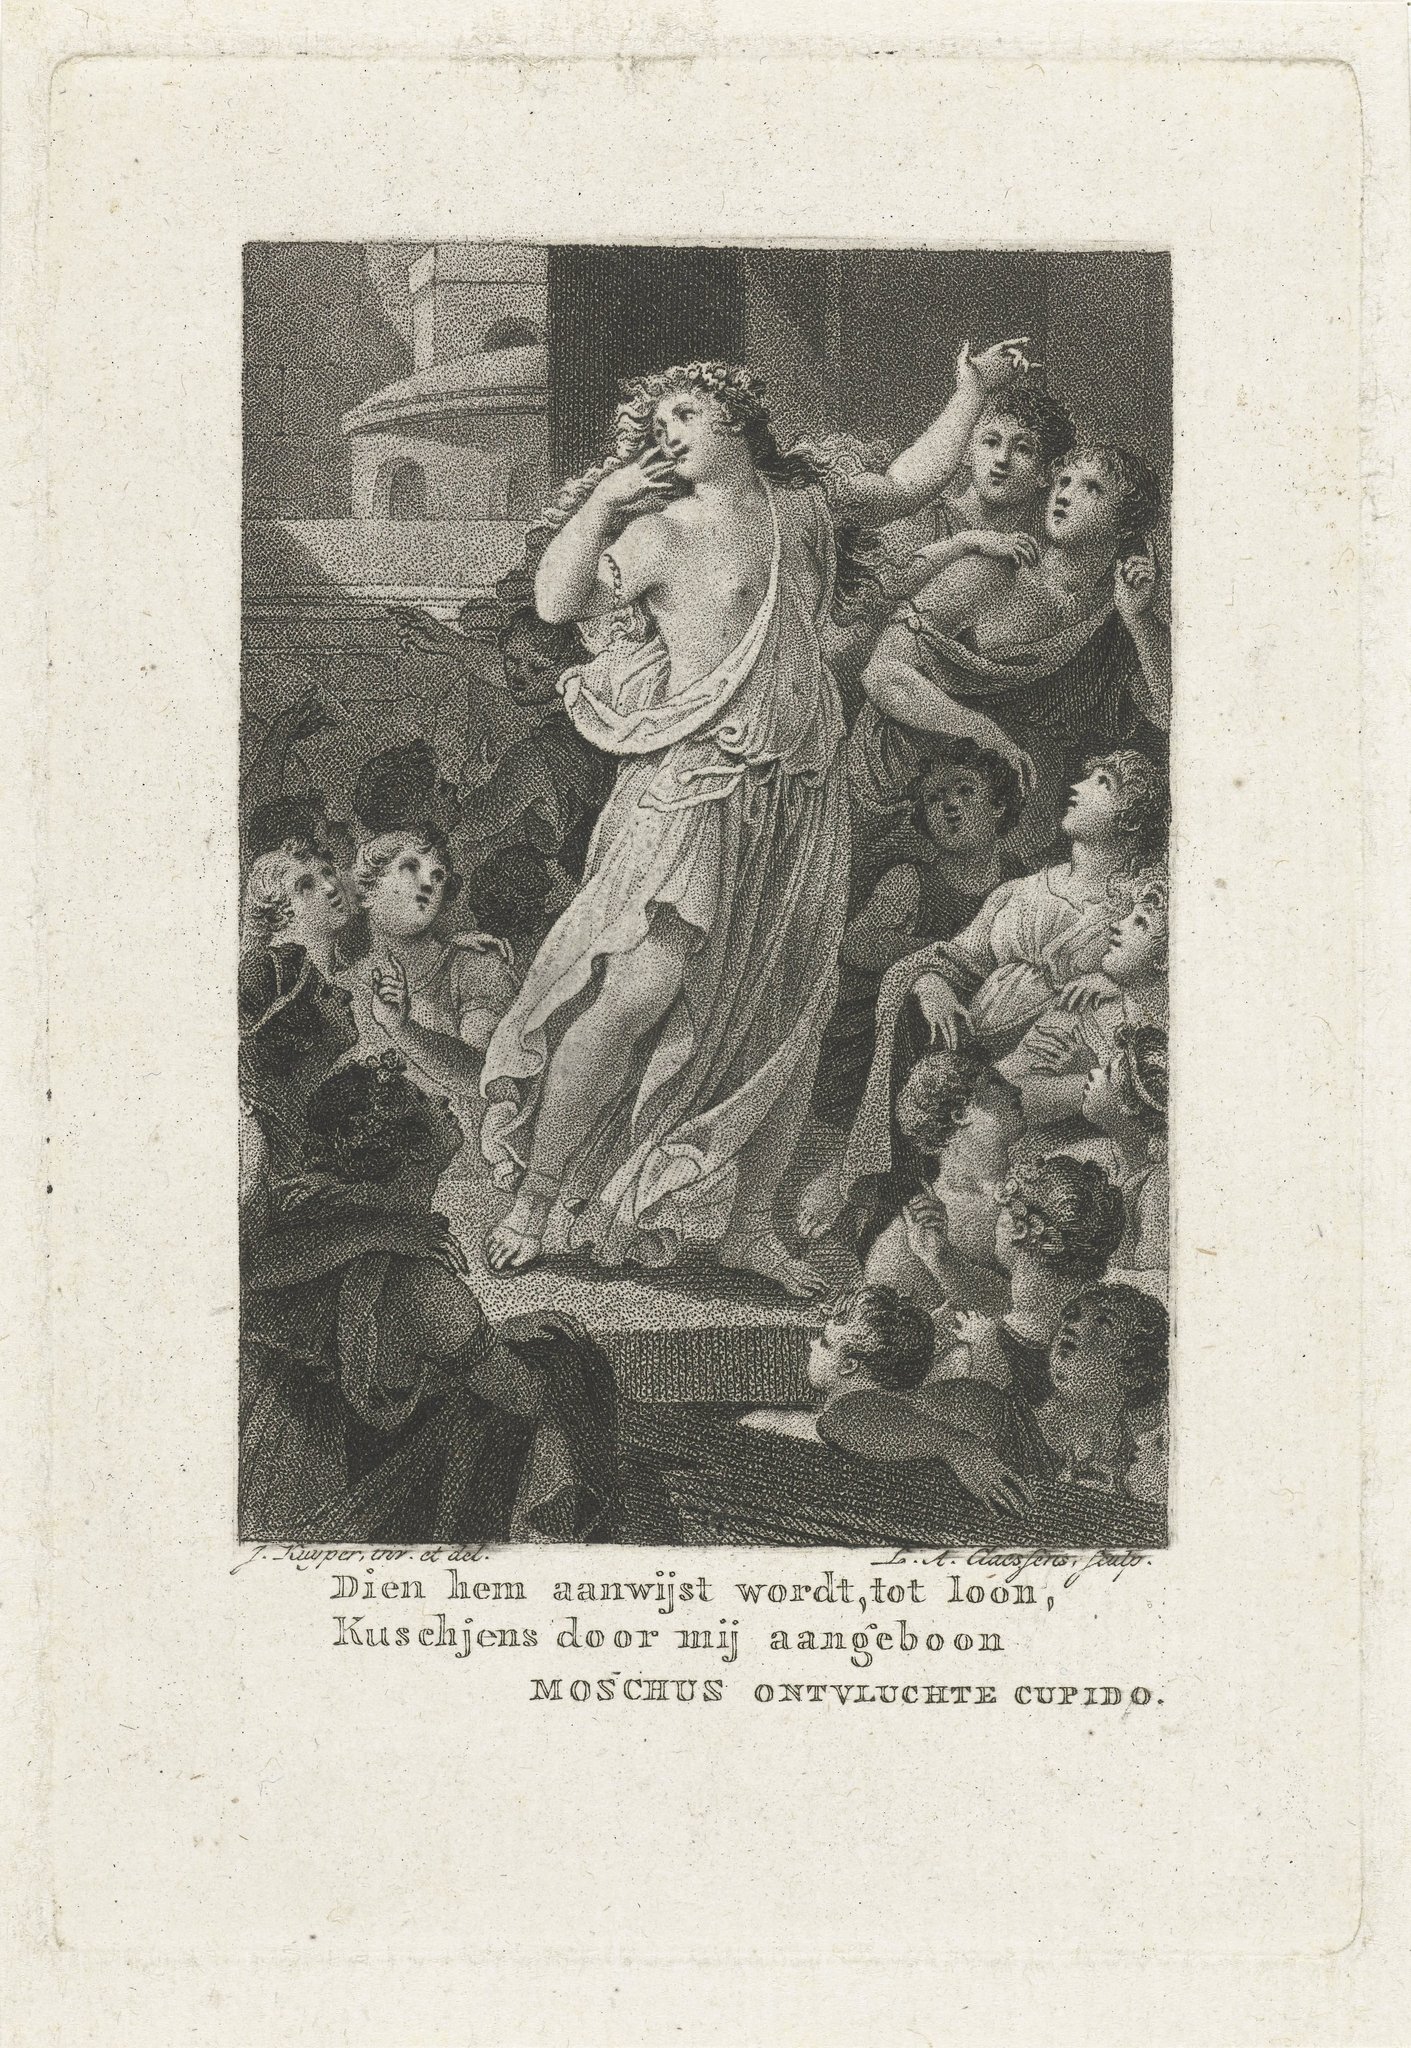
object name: print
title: De voortvluchtige Amor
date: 1803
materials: paper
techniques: etching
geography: amsterdam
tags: venus taking care of cupid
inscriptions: collector's mark: Lugt 2228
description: Illustratie bij een verhaal dat toegeschreven is aan de Griekse dichter Moschus. Amor, hier de zoon van Venus, is weggelopen. Venus is in paniek, ze vraagt aan iedereen om op zoek te gaan naar Amor. Wie hem vindt belooft zij een zoen.